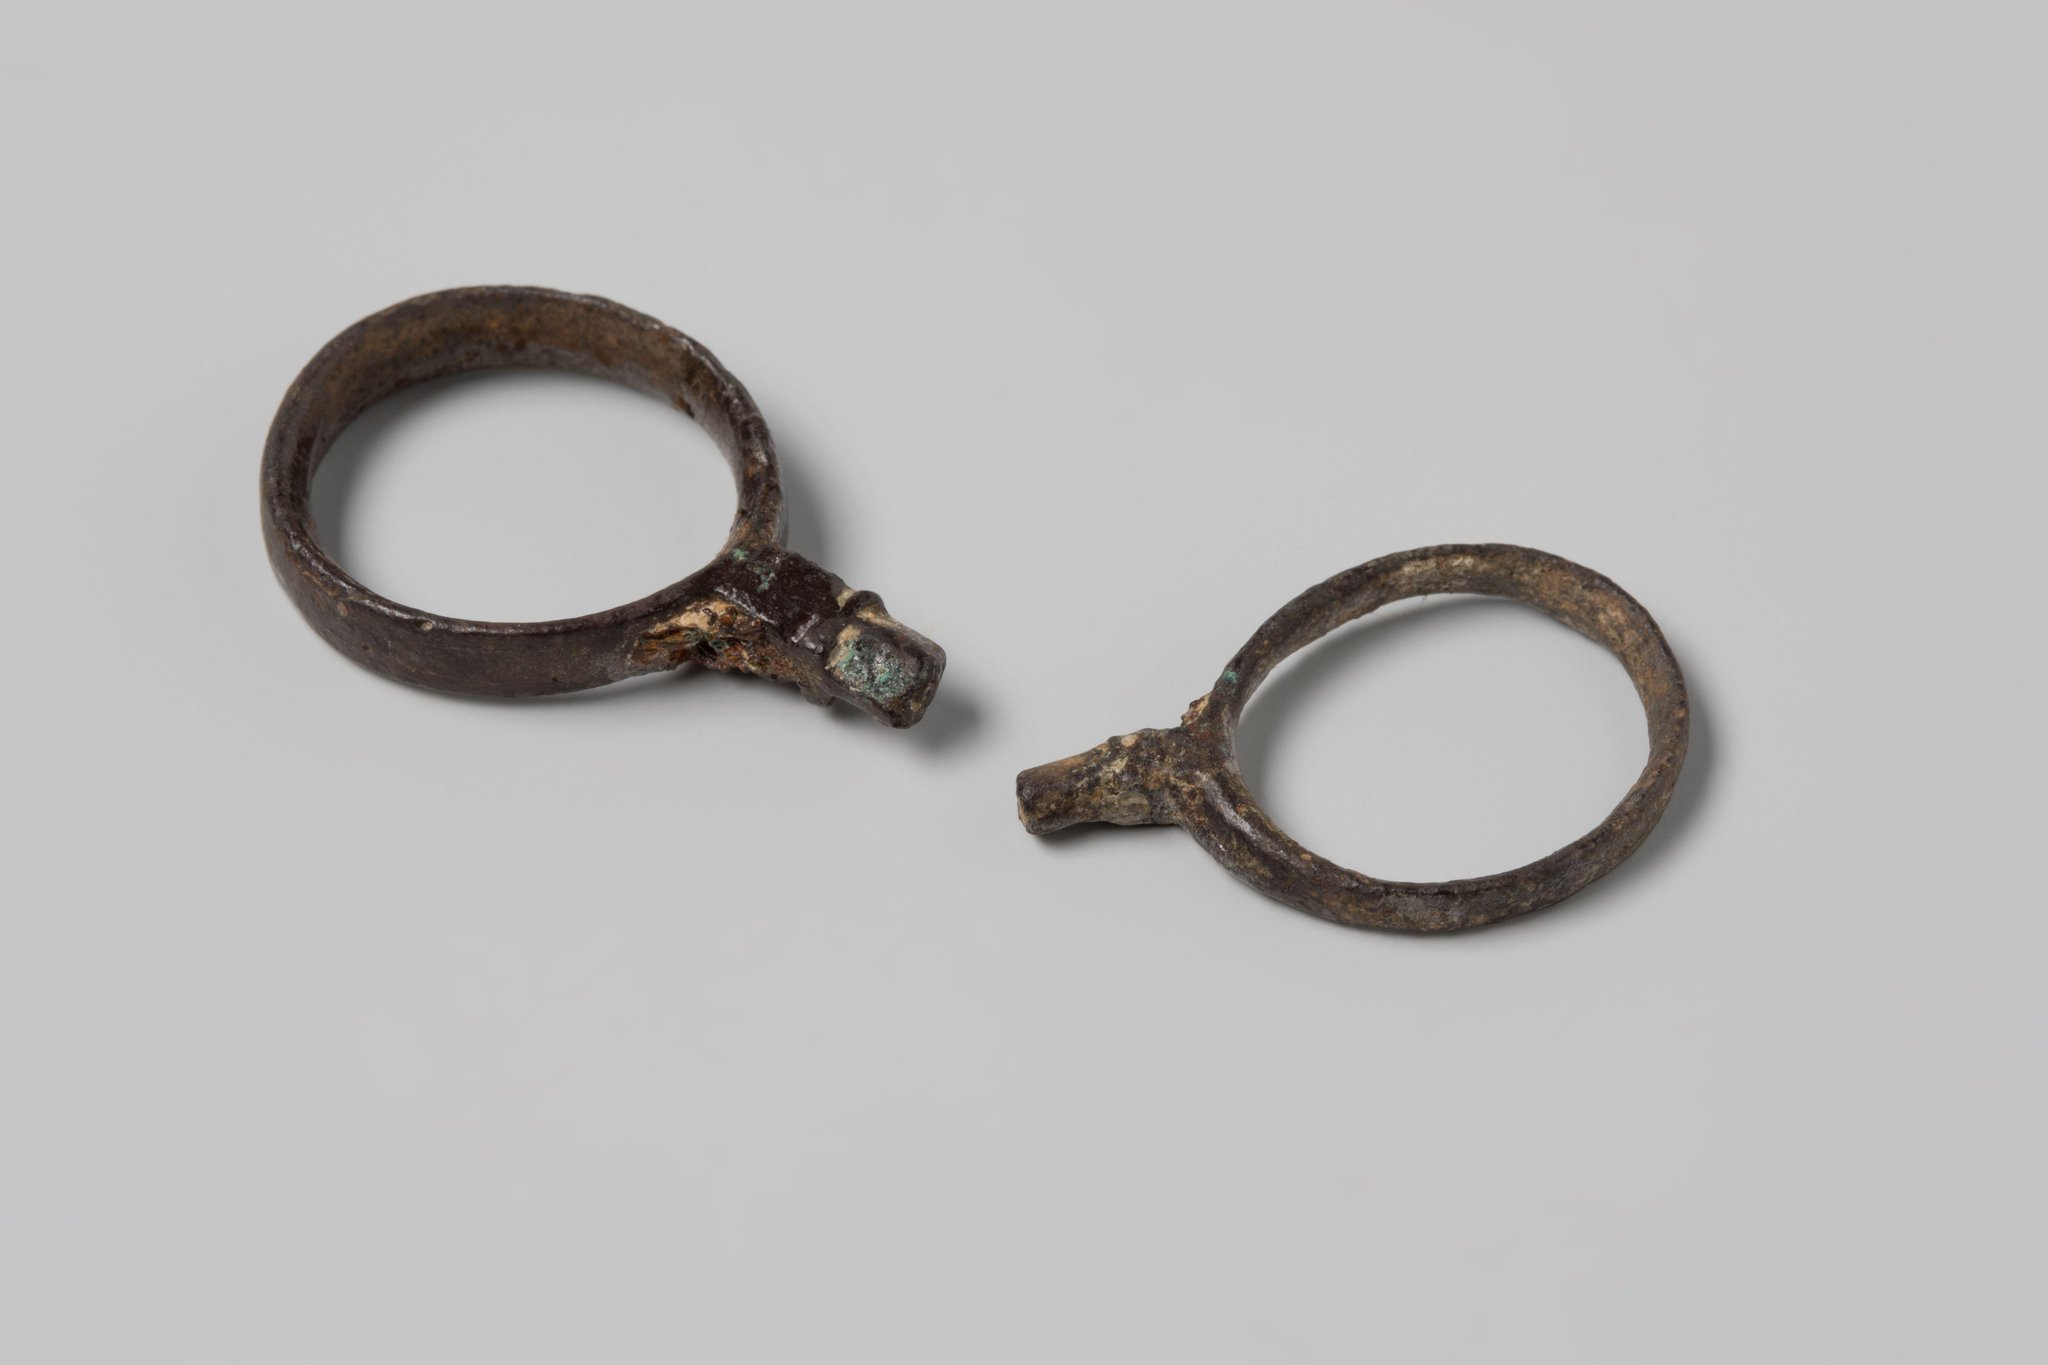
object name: pin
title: Spelden uit het wrak van de Oost-Indiëvaarder Hollandia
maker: Anonymous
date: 1700-1743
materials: copper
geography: netherlands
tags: verenigde oostindische compagnie, hollandia (schip), annet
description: Tools and instruments, sewing and sailmaking, pin; fragm bows, id. NG 1980-27H3265.